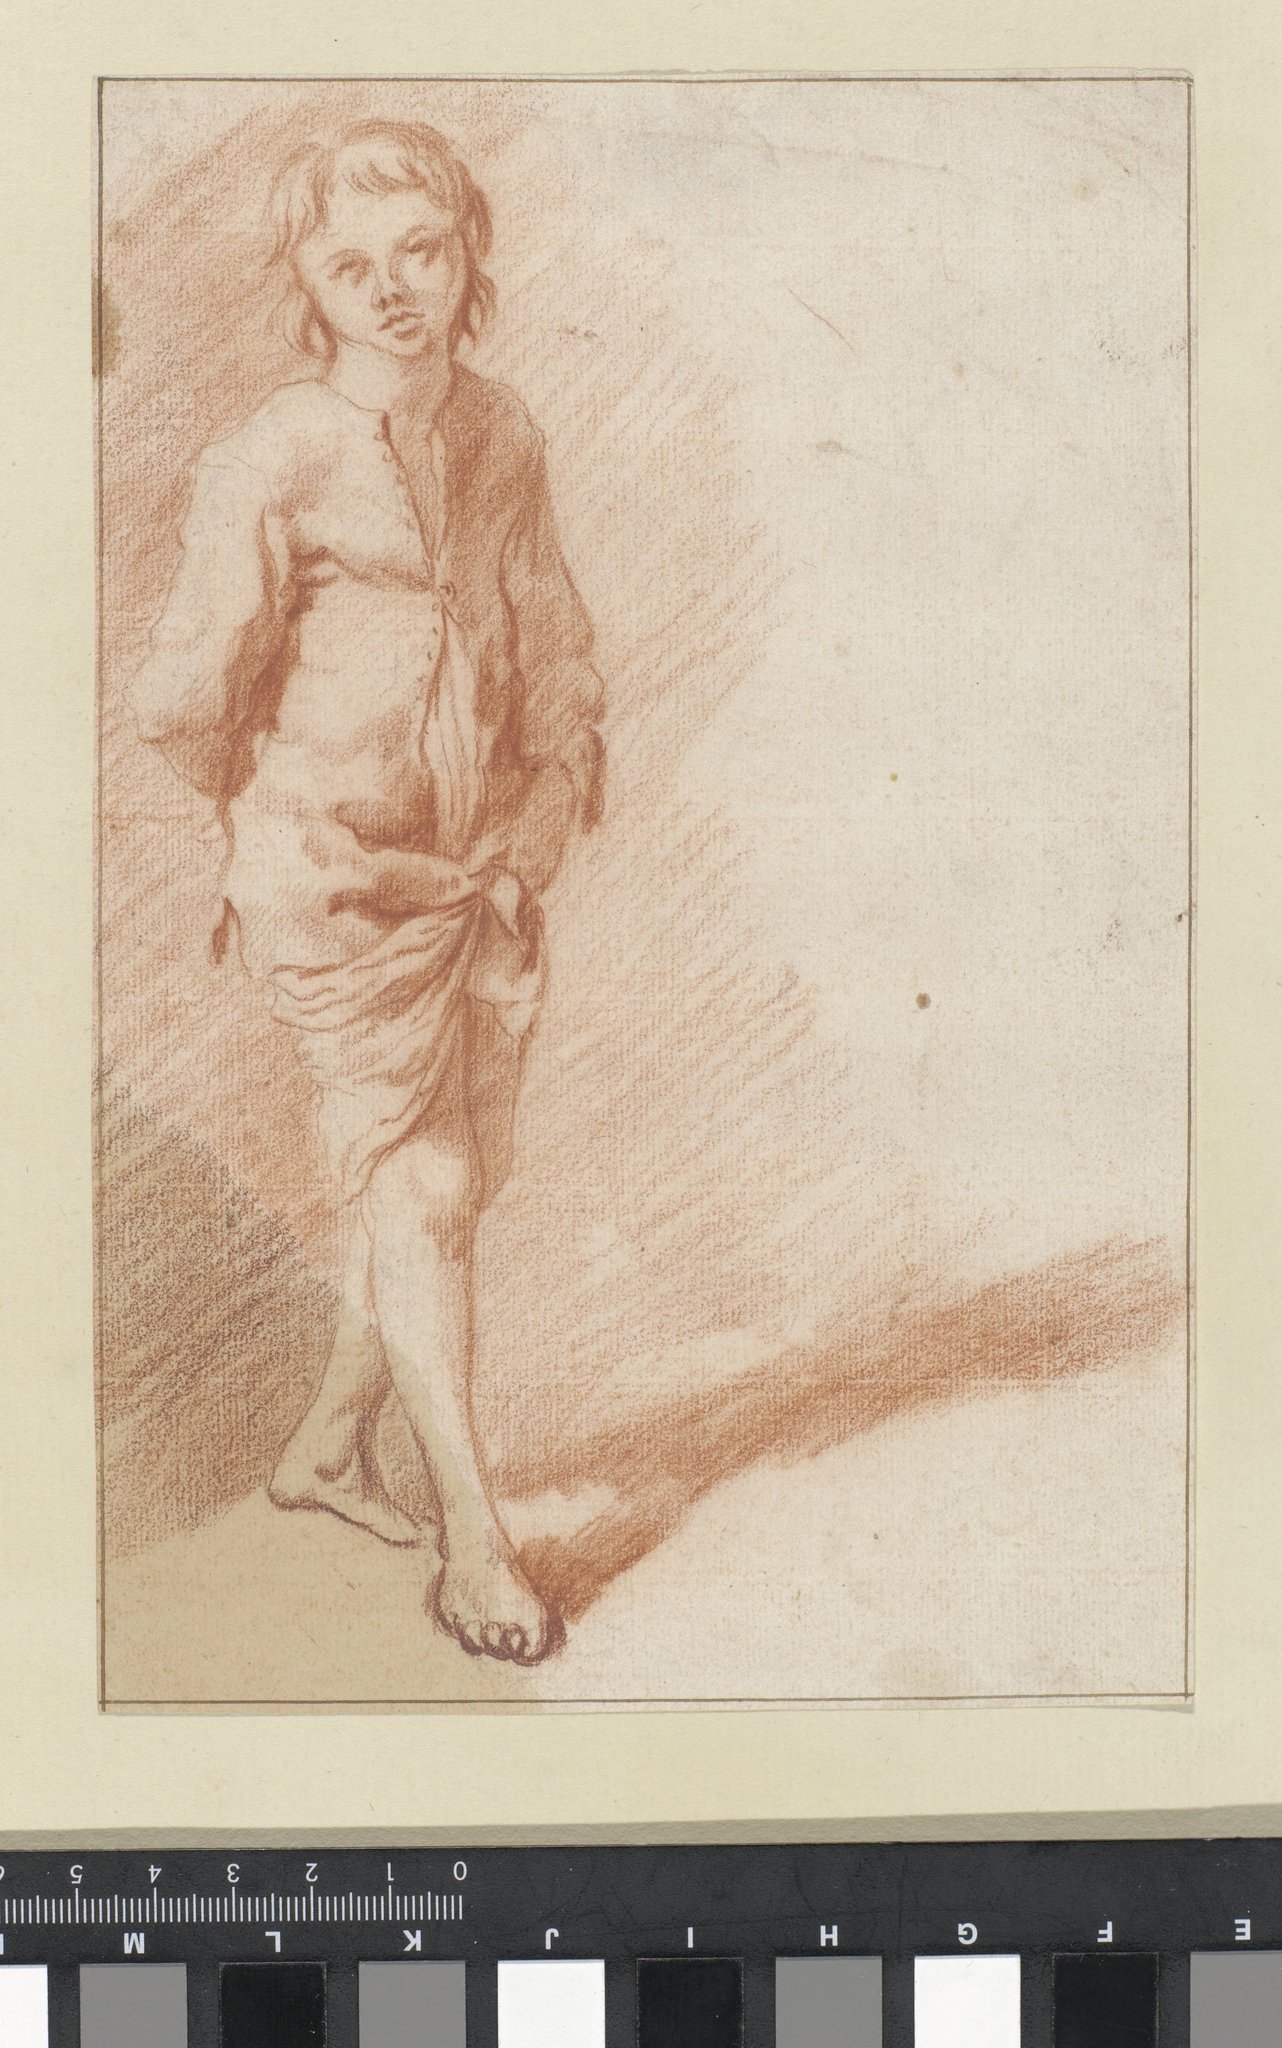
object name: drawing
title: Staande jongen op blote voeten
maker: Anonymous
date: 1700-1799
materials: chalk, paper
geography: netherlands